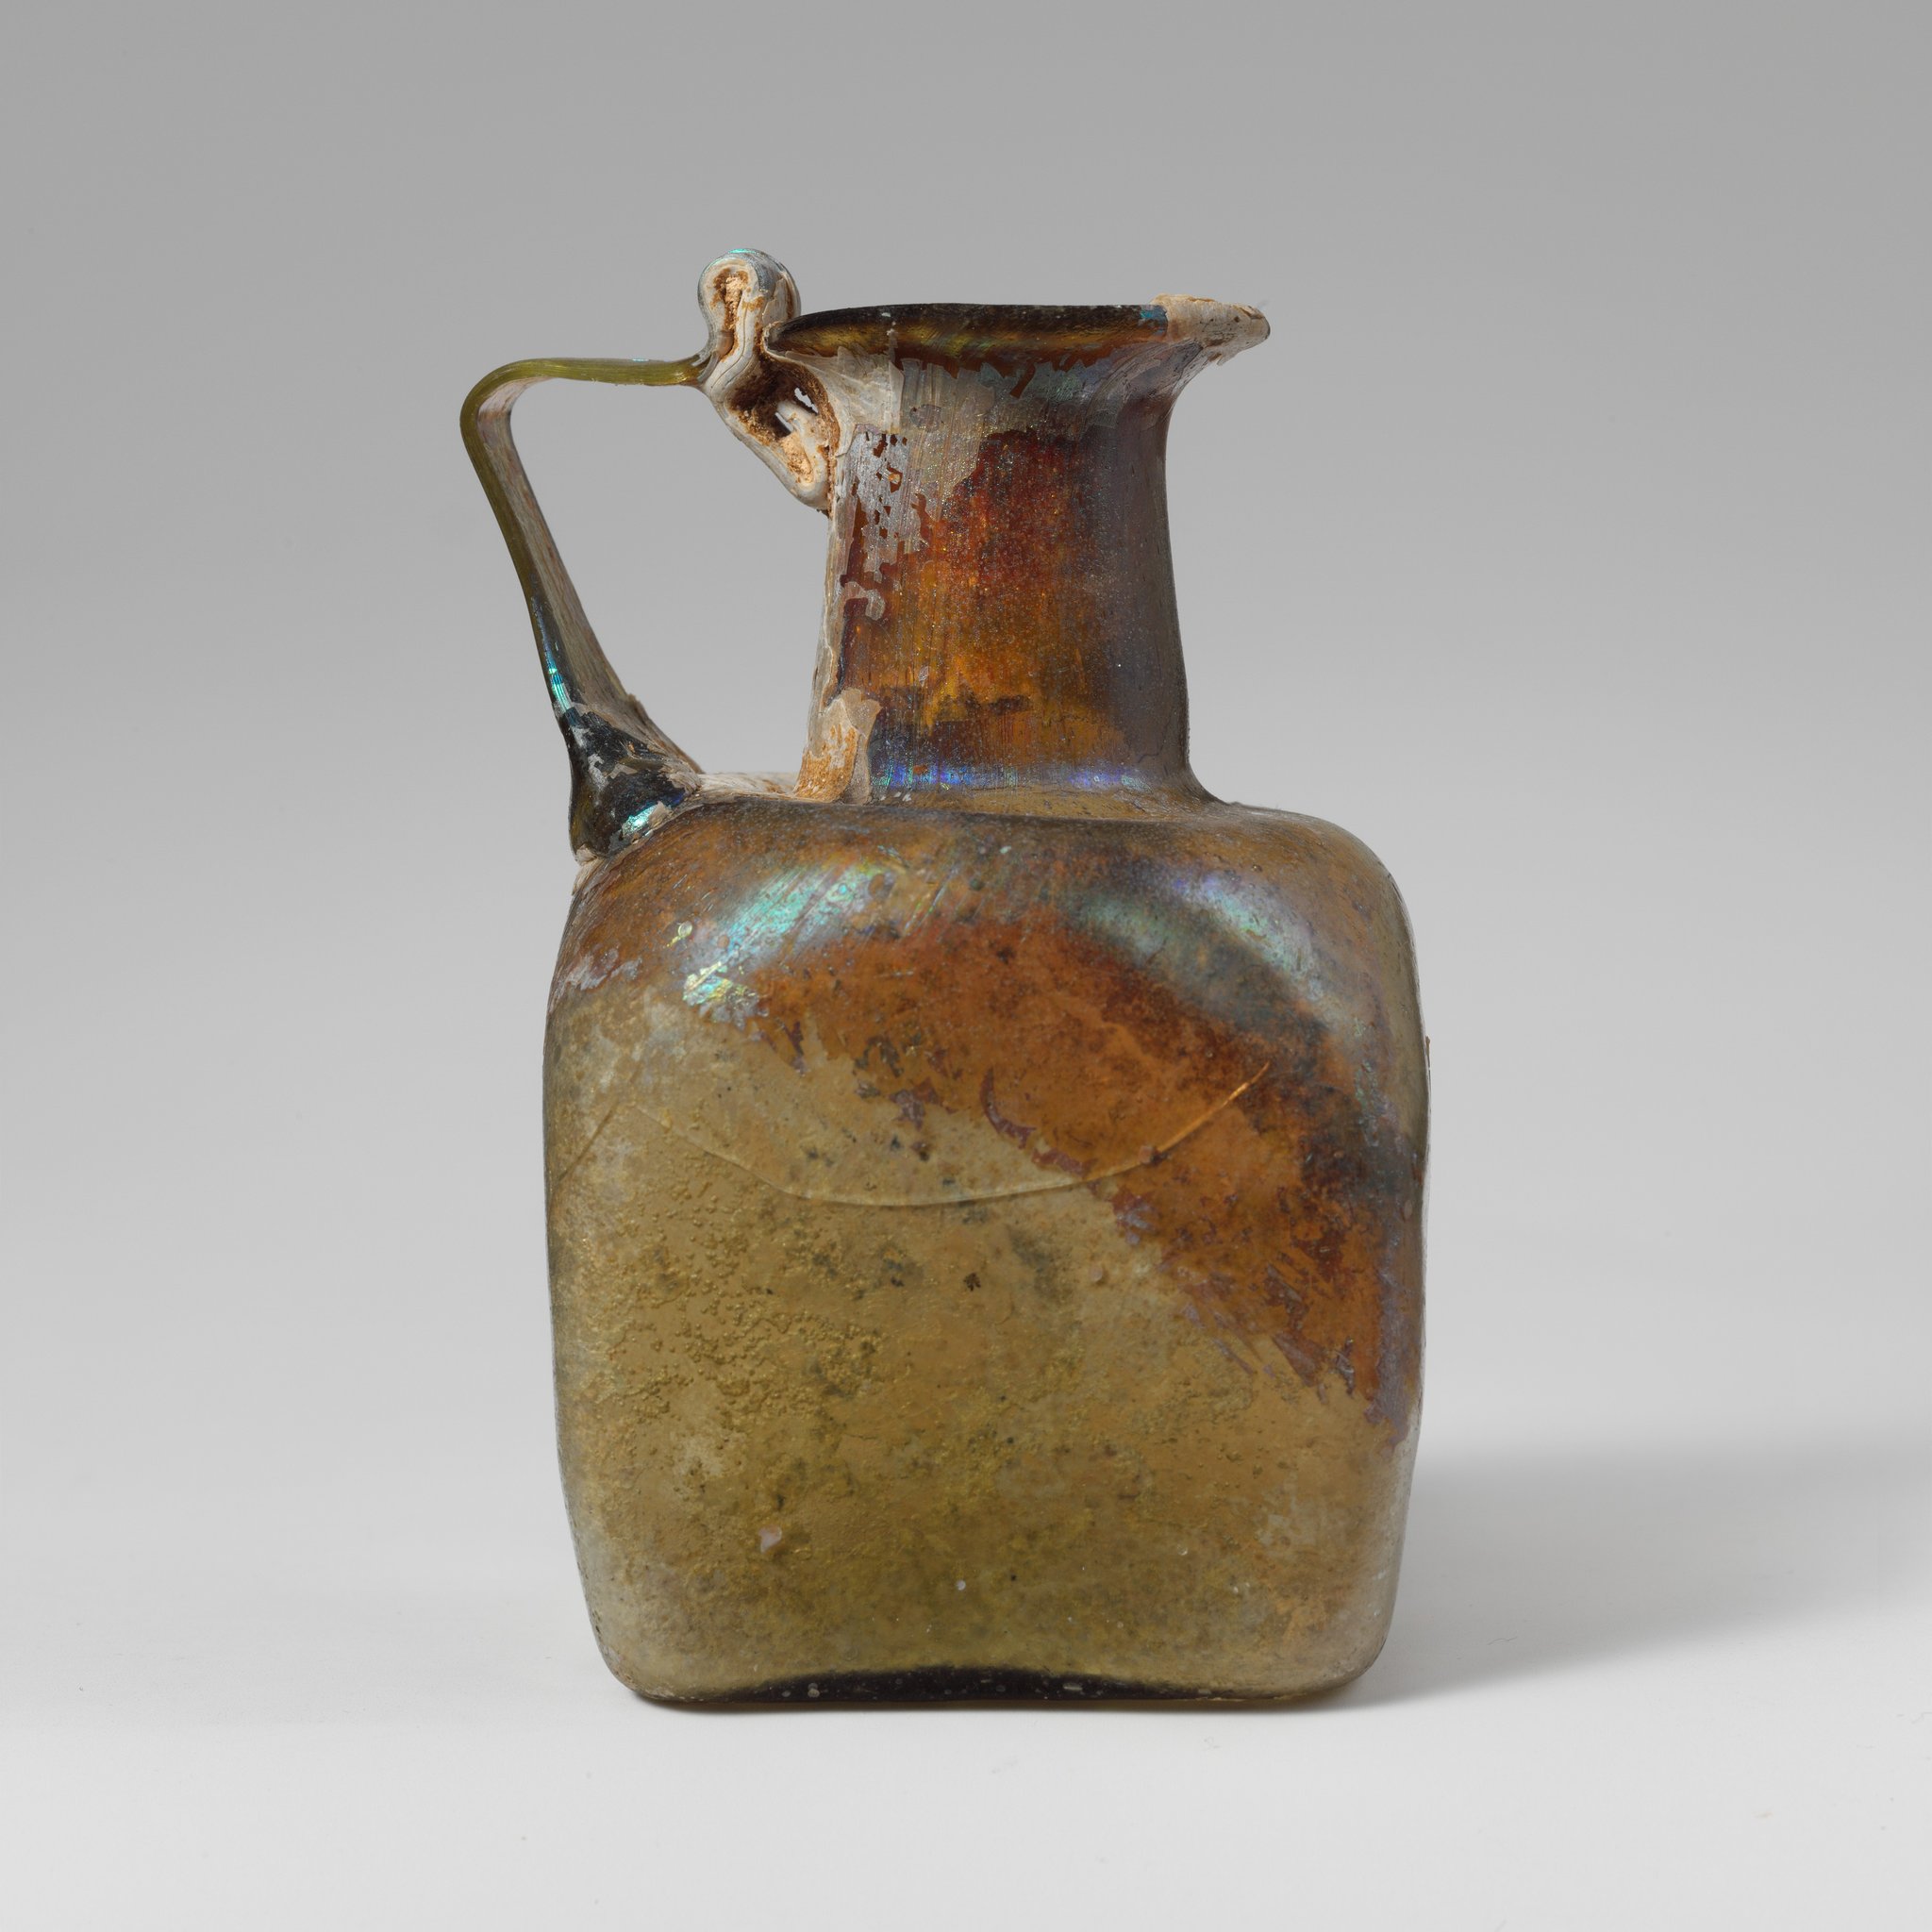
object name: bottle, square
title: Glass square bottle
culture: roman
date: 101-300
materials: glass